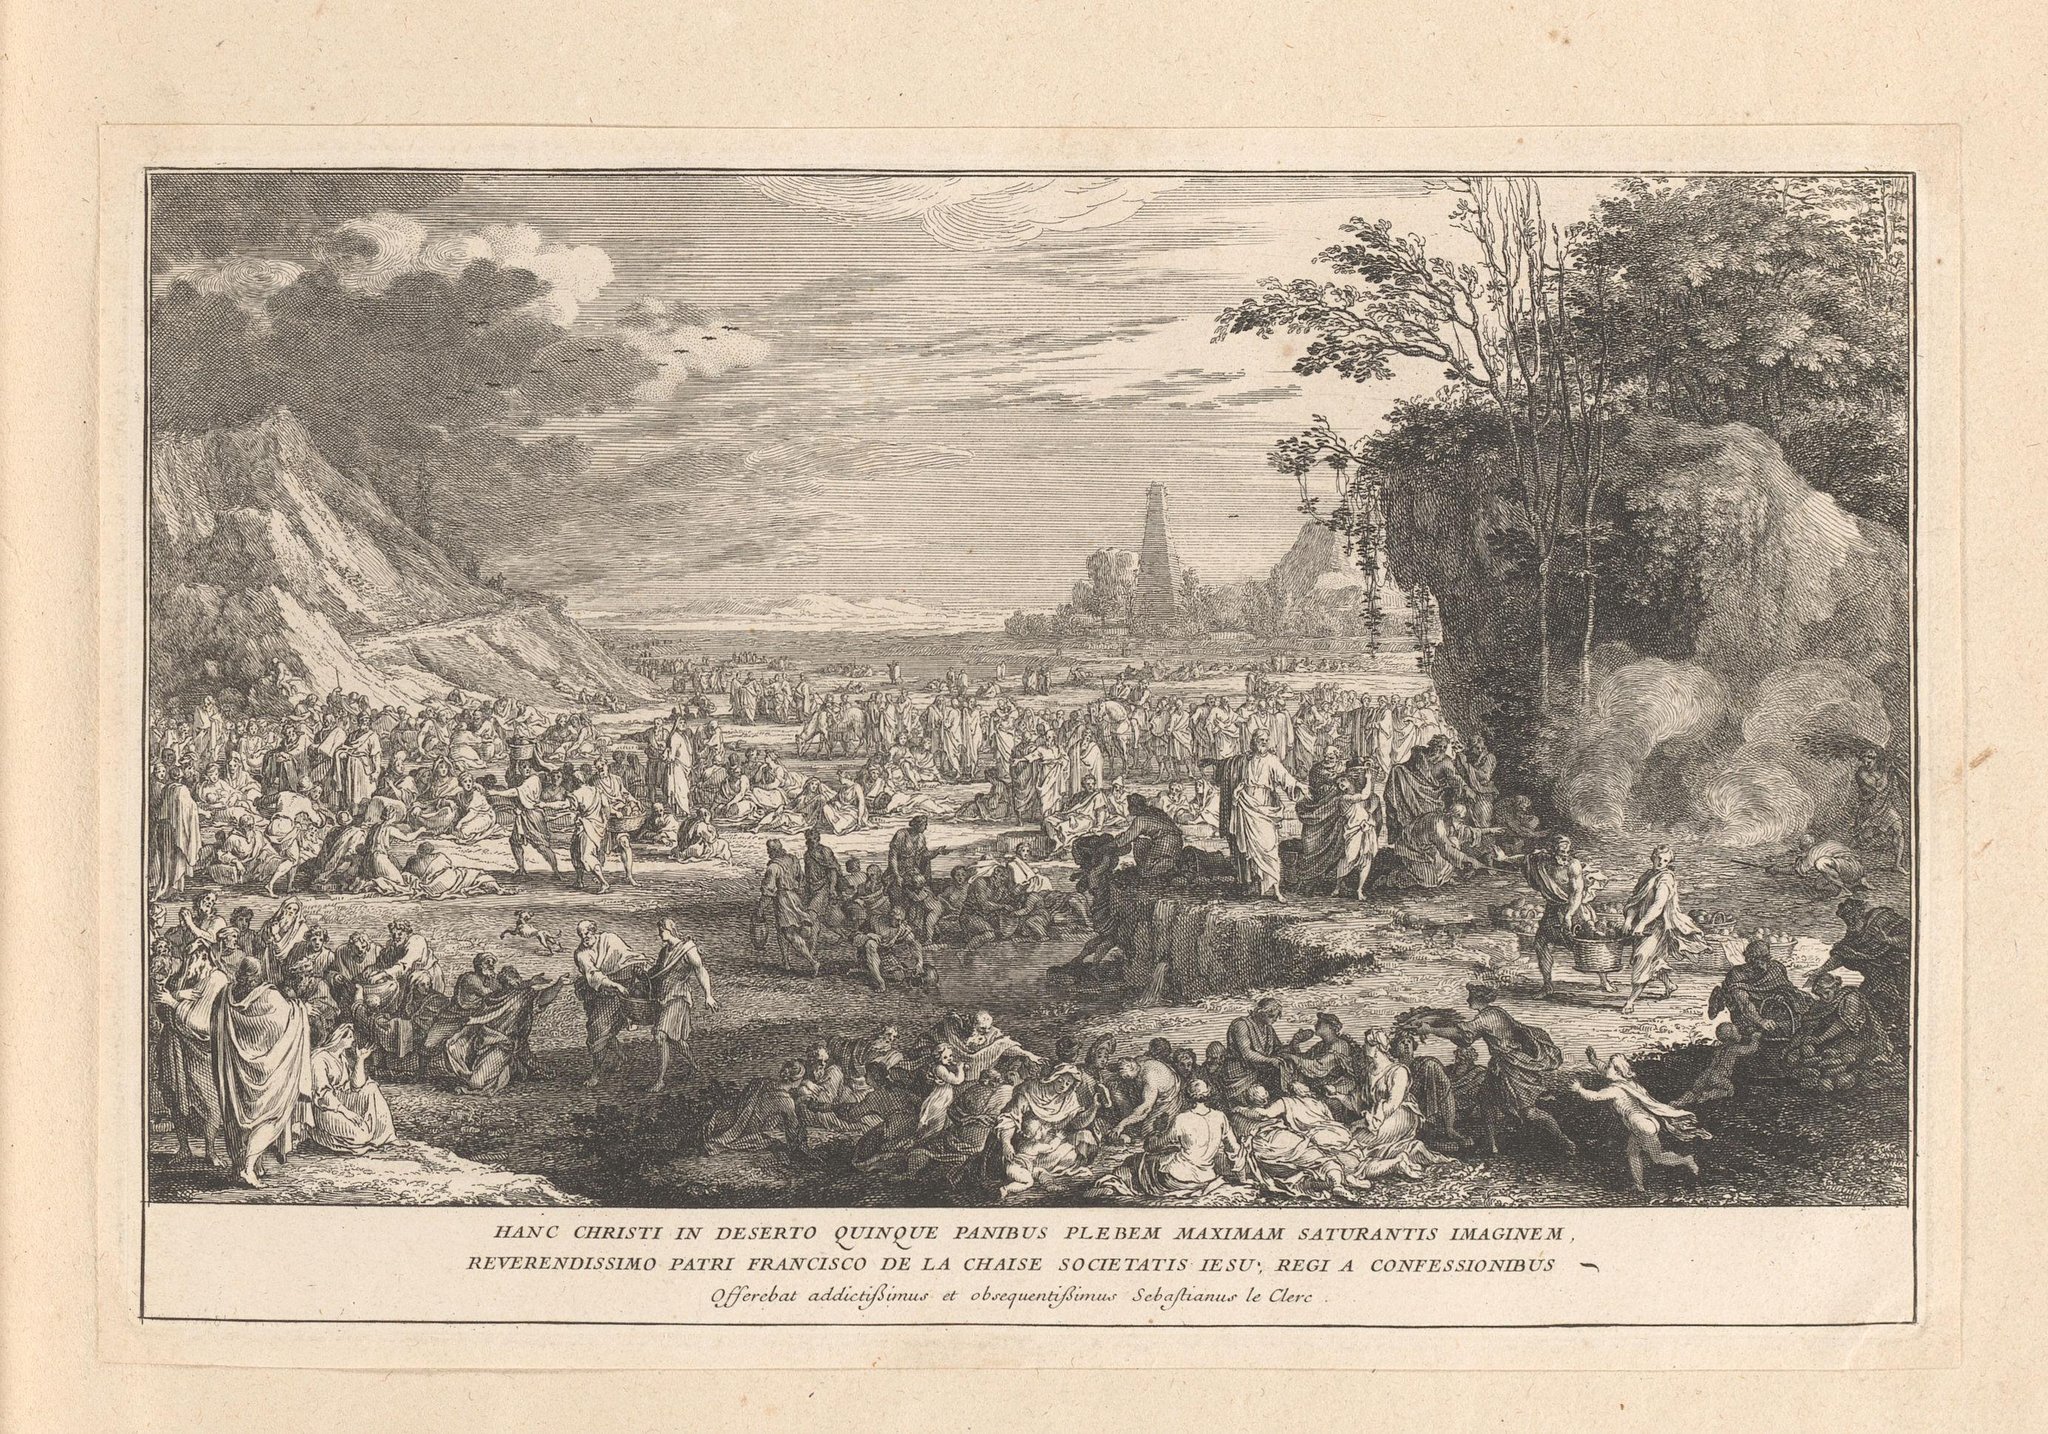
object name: album leaf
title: Hanc Christi in deserto (...)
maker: sébastien leclerc (i)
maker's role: print maker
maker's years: 1637-1714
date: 1696-1697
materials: paper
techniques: engraving, etching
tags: multiplication of loaves and fishes for a multitude of four or five thousand people (matthew 14:13-21, 15:32-39; mark 6:32-44, 8:1-10; luke 9:10-17; john 6:1-14)